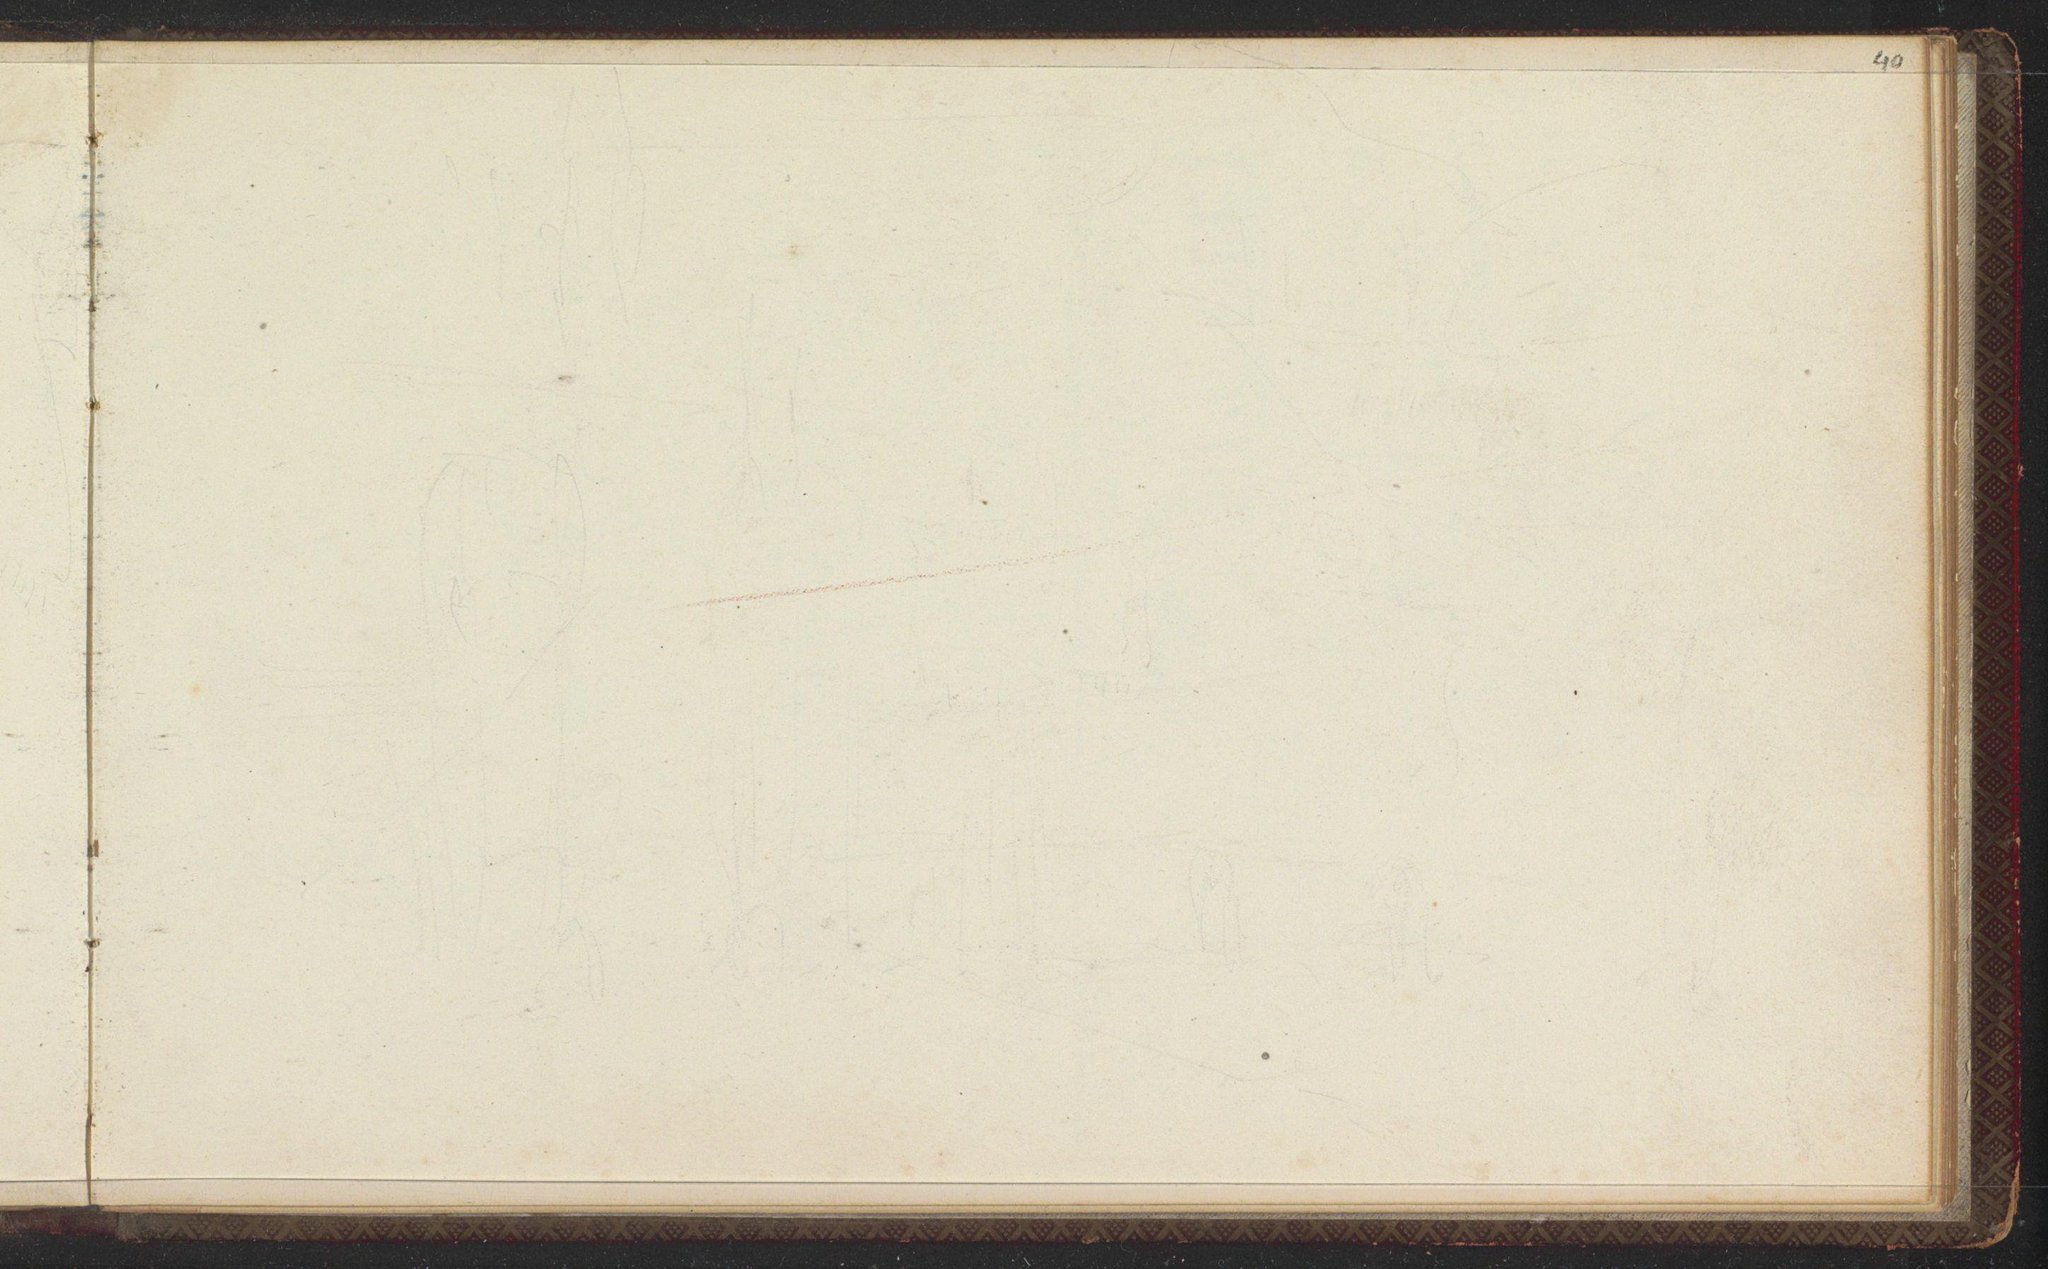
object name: sketchbook leaf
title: Studie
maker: adrianus eversen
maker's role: draughtsman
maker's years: 1818-1897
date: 1828-1897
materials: paper, pencil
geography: netherlands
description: Studie. Blad 40 uit een schetsboek met 52 bladen vervaardigd in de omgeving van Kampen, Hattem, Hoorn en Zwolle.